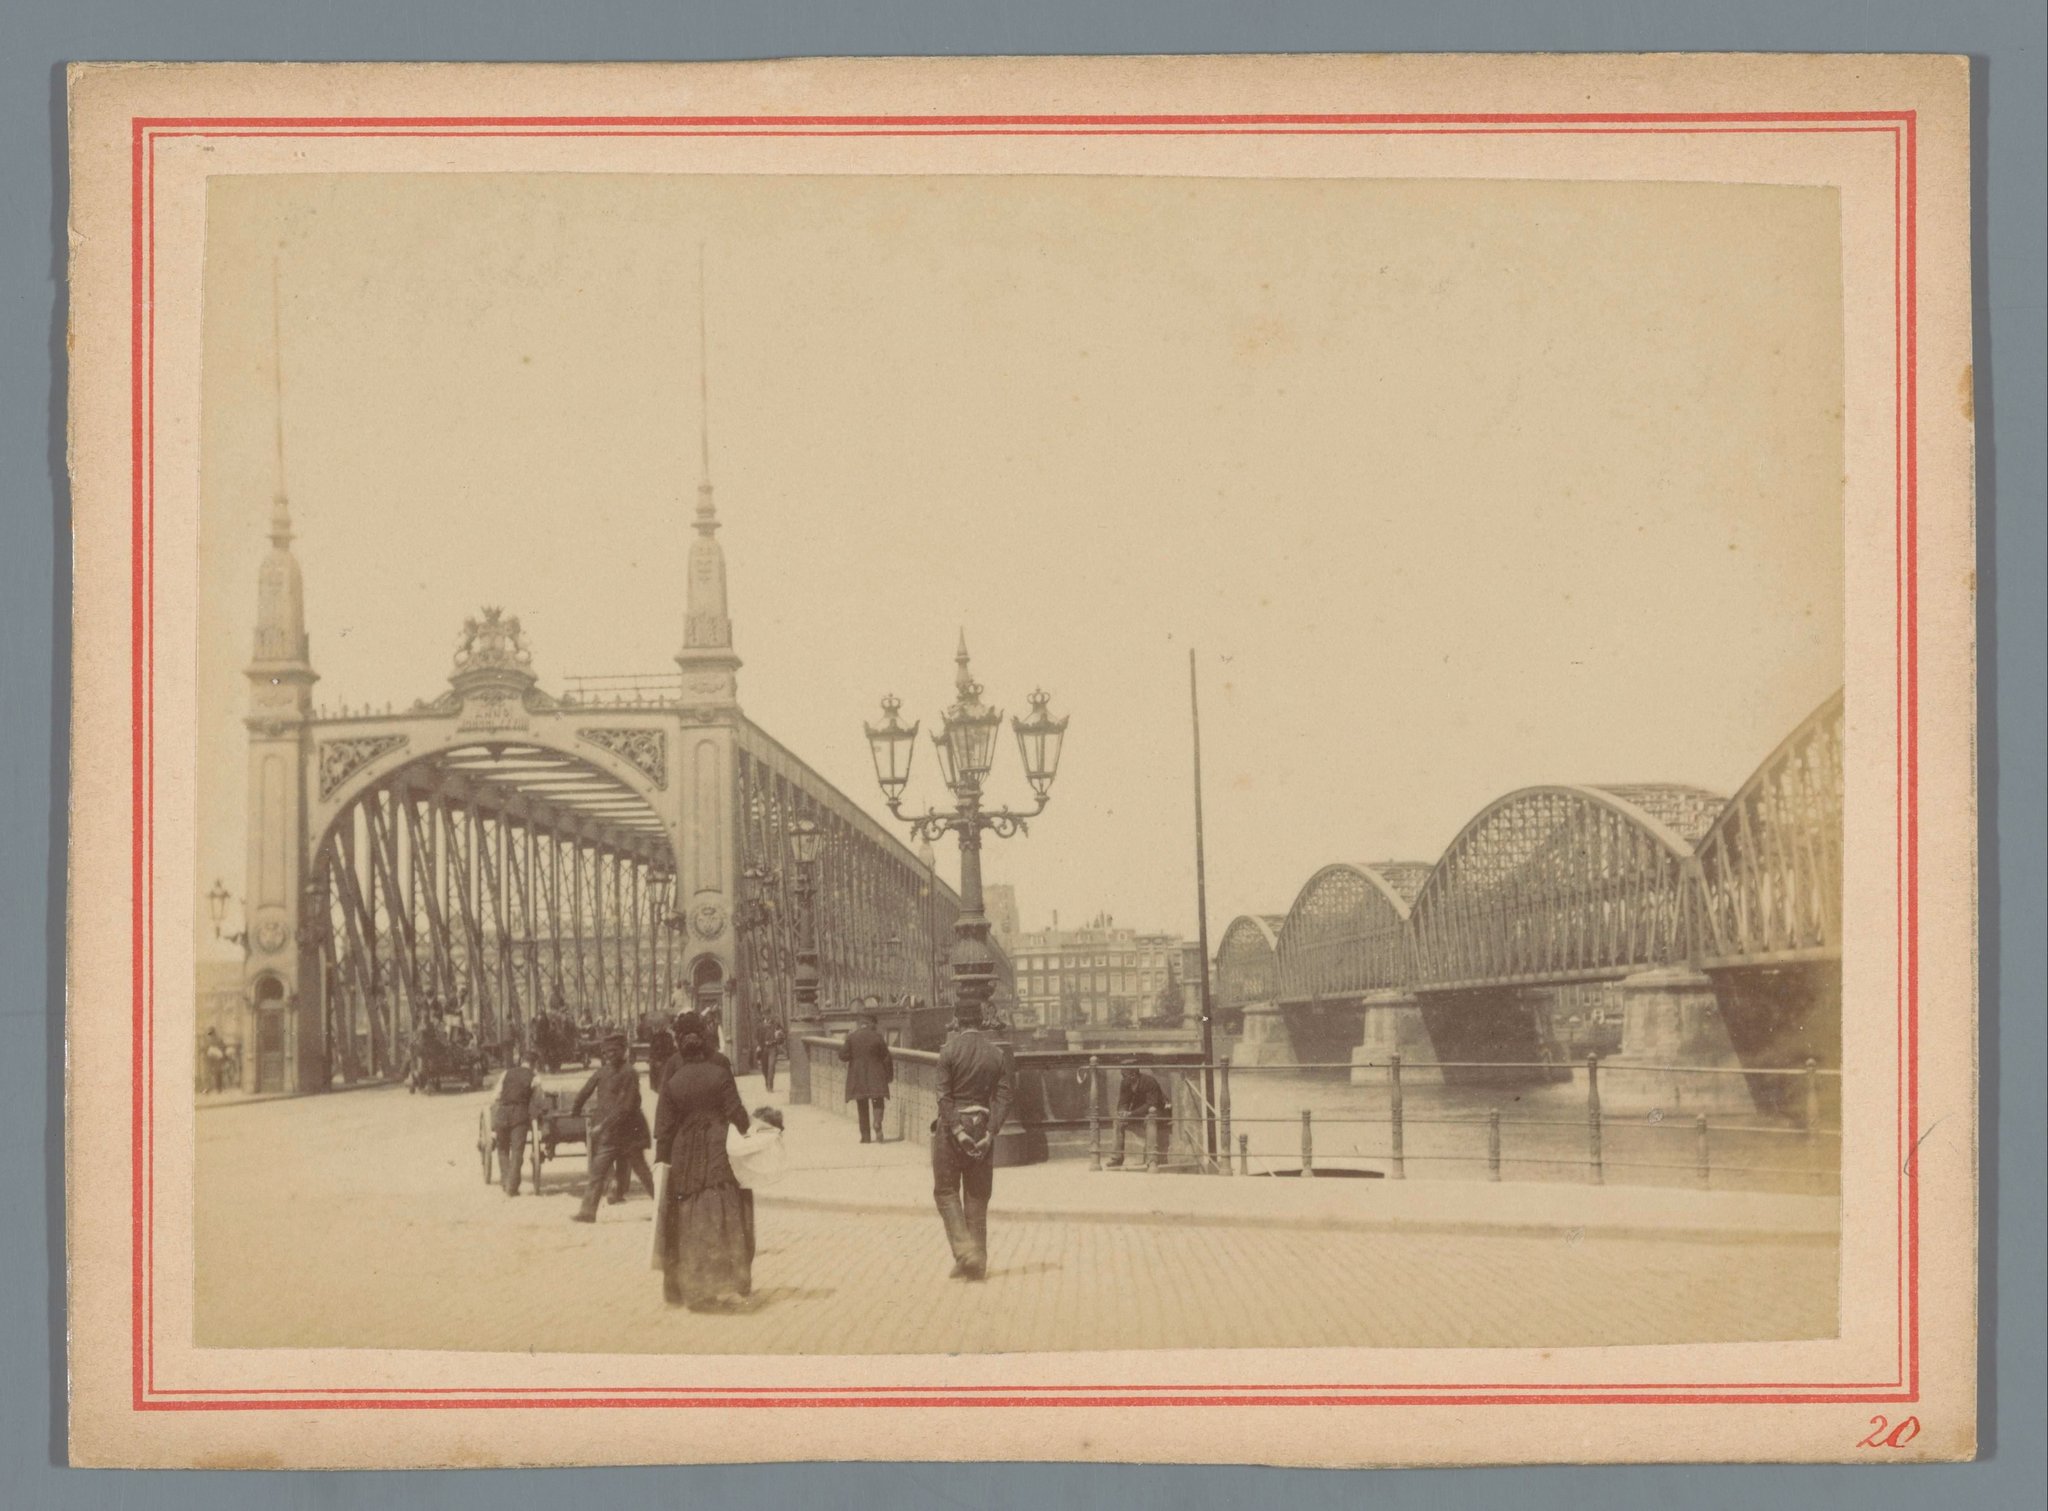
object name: cabinet photograph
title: Gezicht vanaf het Noordereiland op de Maasbruggen te Rotterdam met links de Willemsbrug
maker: Anonymous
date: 1877-1885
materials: cardboard, photographic support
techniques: albumen print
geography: rotterdam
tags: canals, waters (in city), bridge in city across river, canal, etc.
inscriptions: inscription: ‘Rotterdam/ Maas Bruggen’